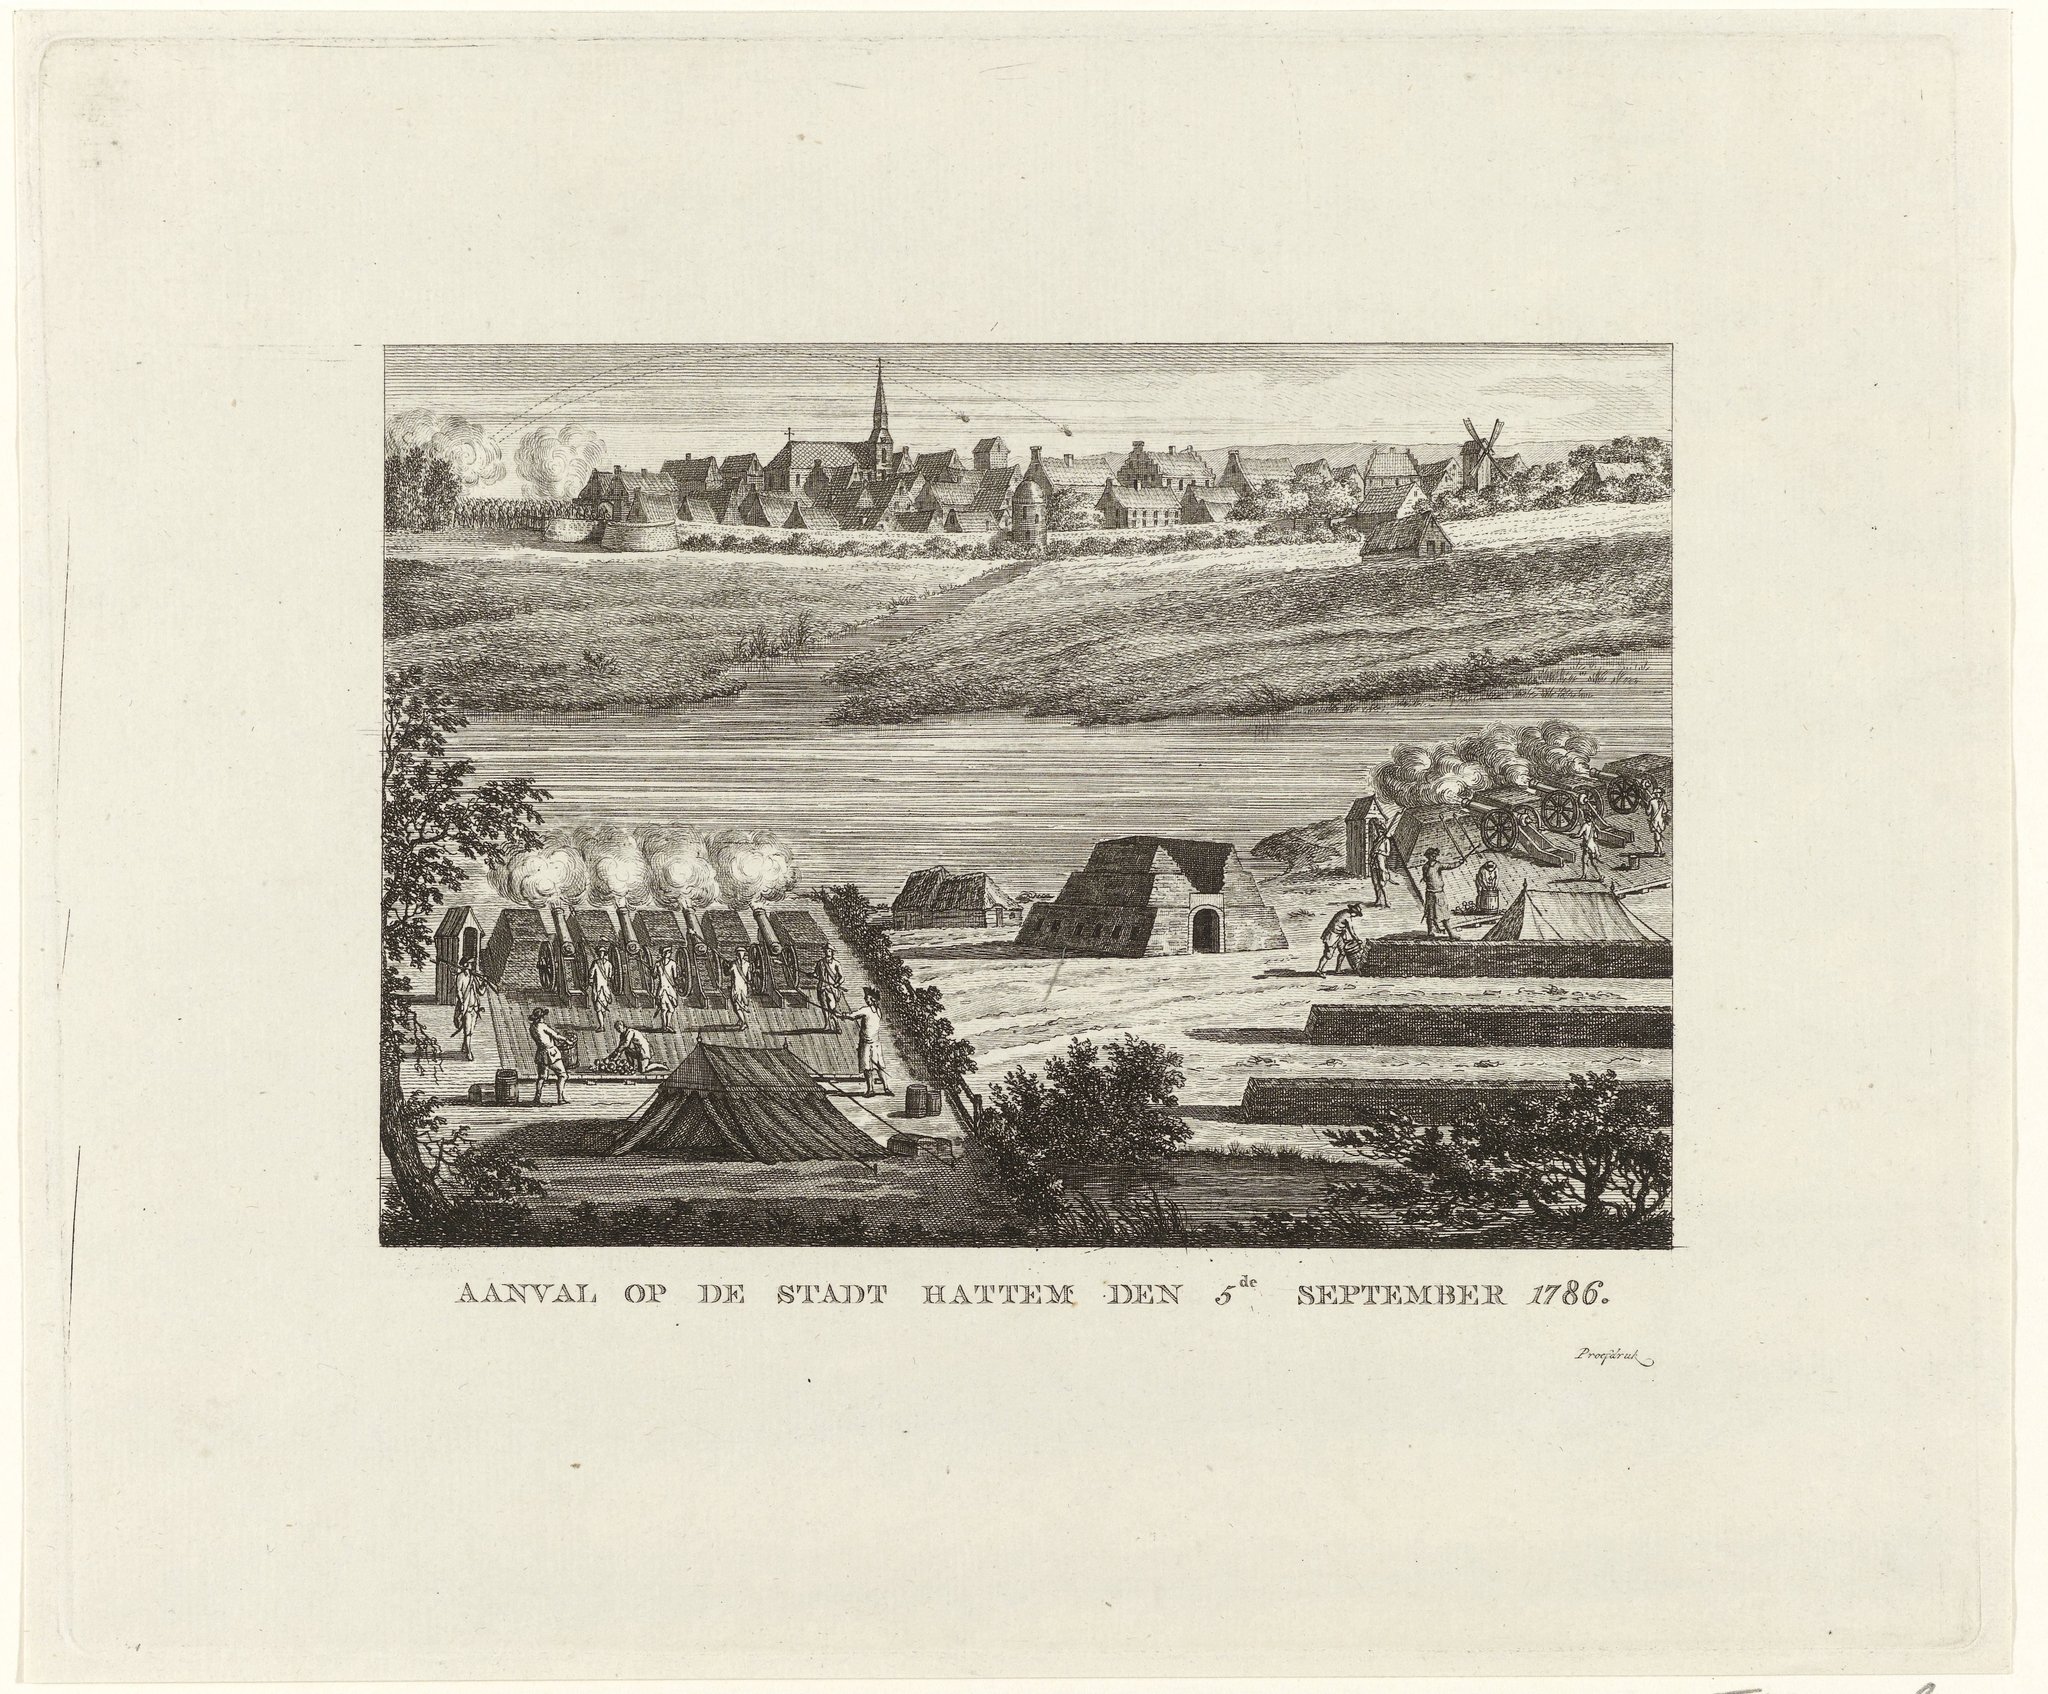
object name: print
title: Aanval op de stadt Hattem den 5de September 1786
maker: Anonymous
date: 1786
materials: paper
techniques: engraving, etching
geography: northern netherlands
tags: bombardment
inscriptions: collector's mark: Lugt 2228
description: Beschieting van de stad Hattem door de stadhouderlijke troepen, 5 september 1786.